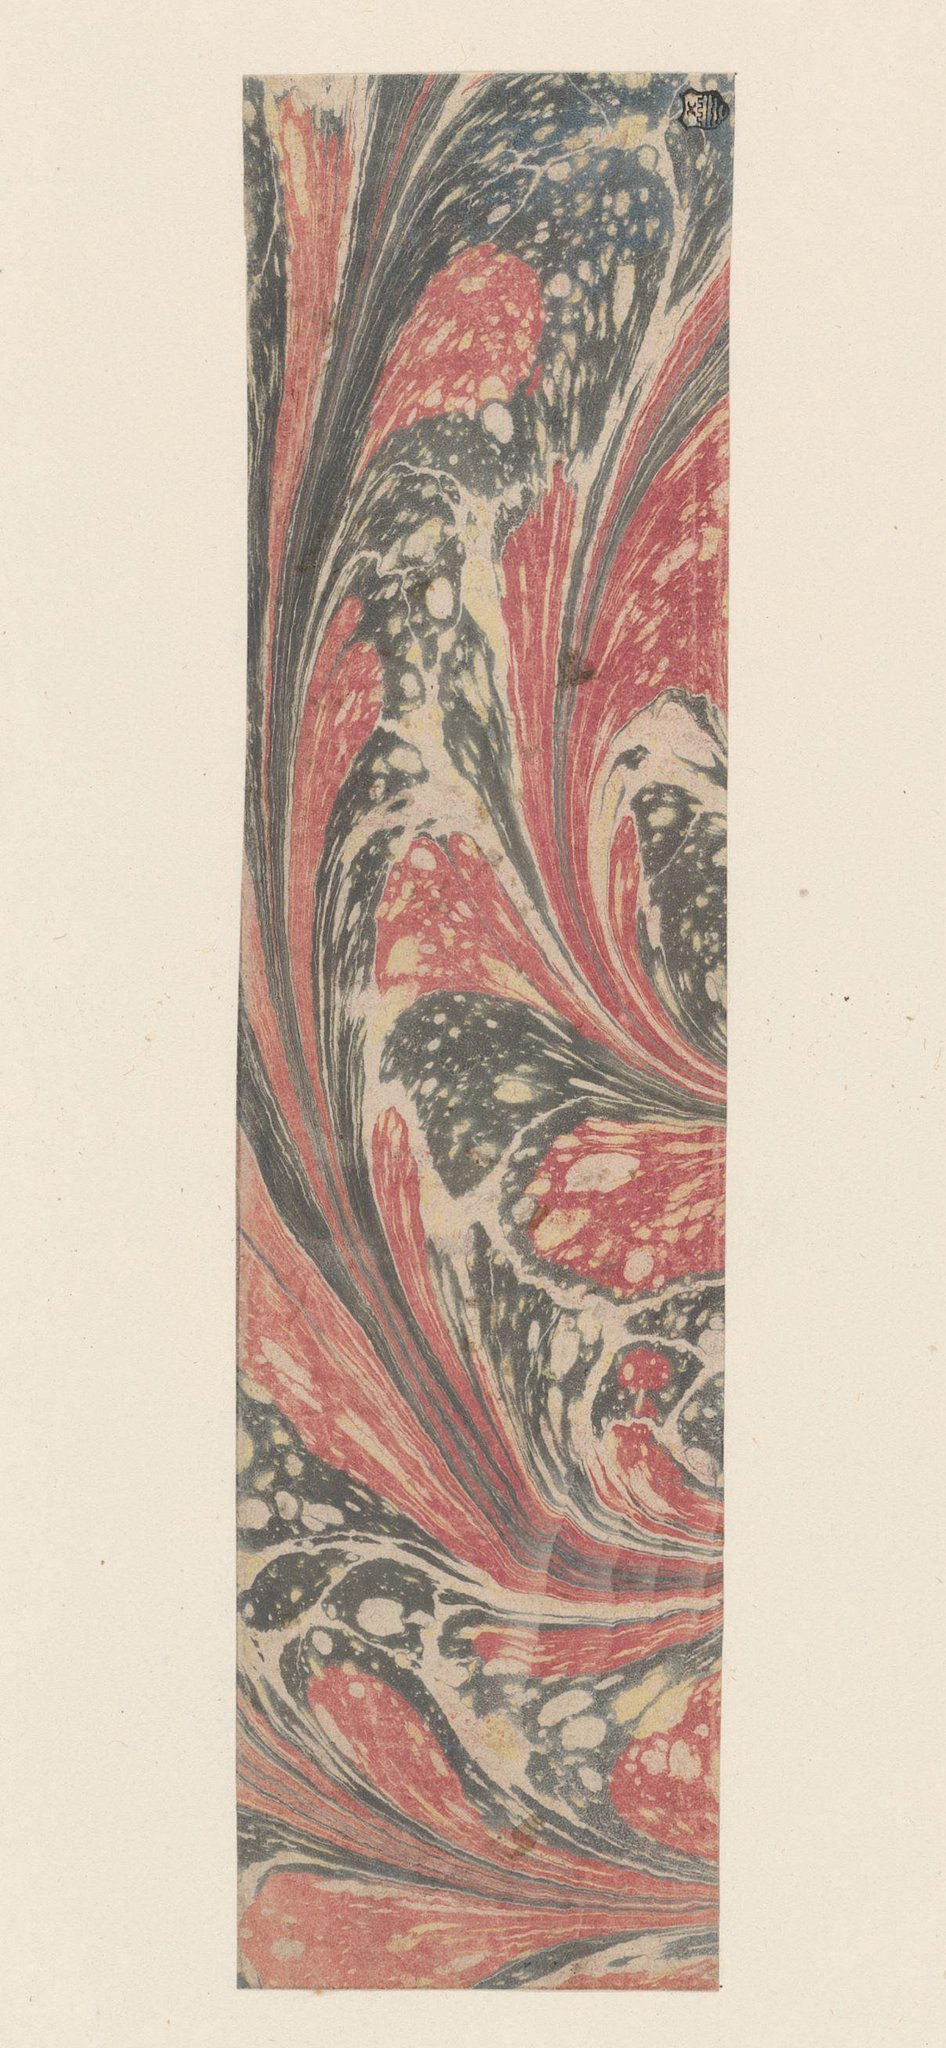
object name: marbled paper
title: Golfmarmer in groen, rood en geel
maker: Anonymous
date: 1700-1850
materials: paint, paper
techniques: wave marble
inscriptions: collector's mark: Lugt 2760